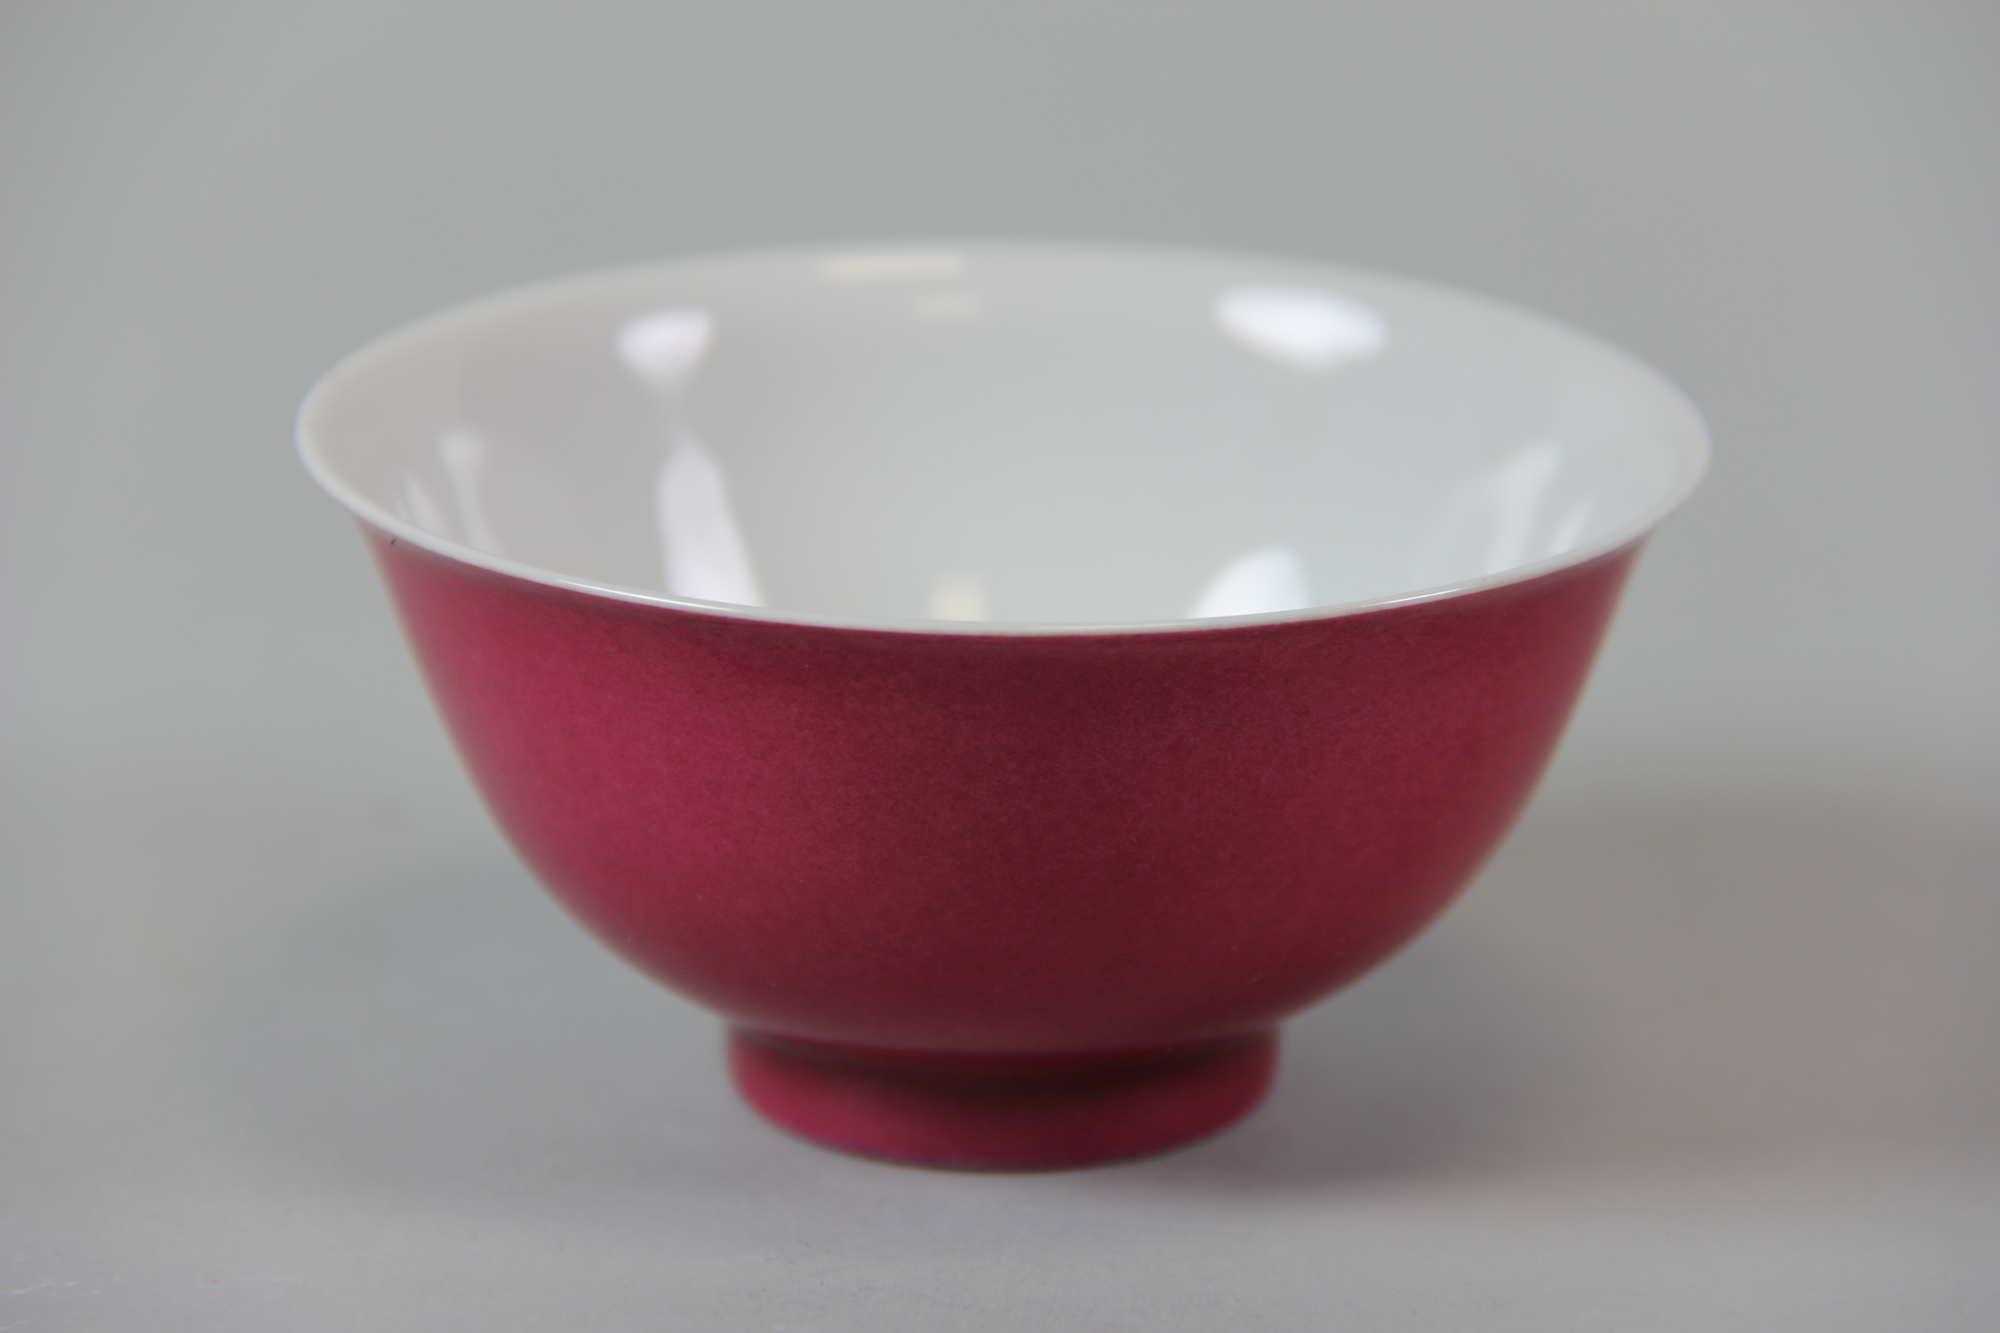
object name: cup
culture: chinese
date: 1723-1735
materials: porcelain